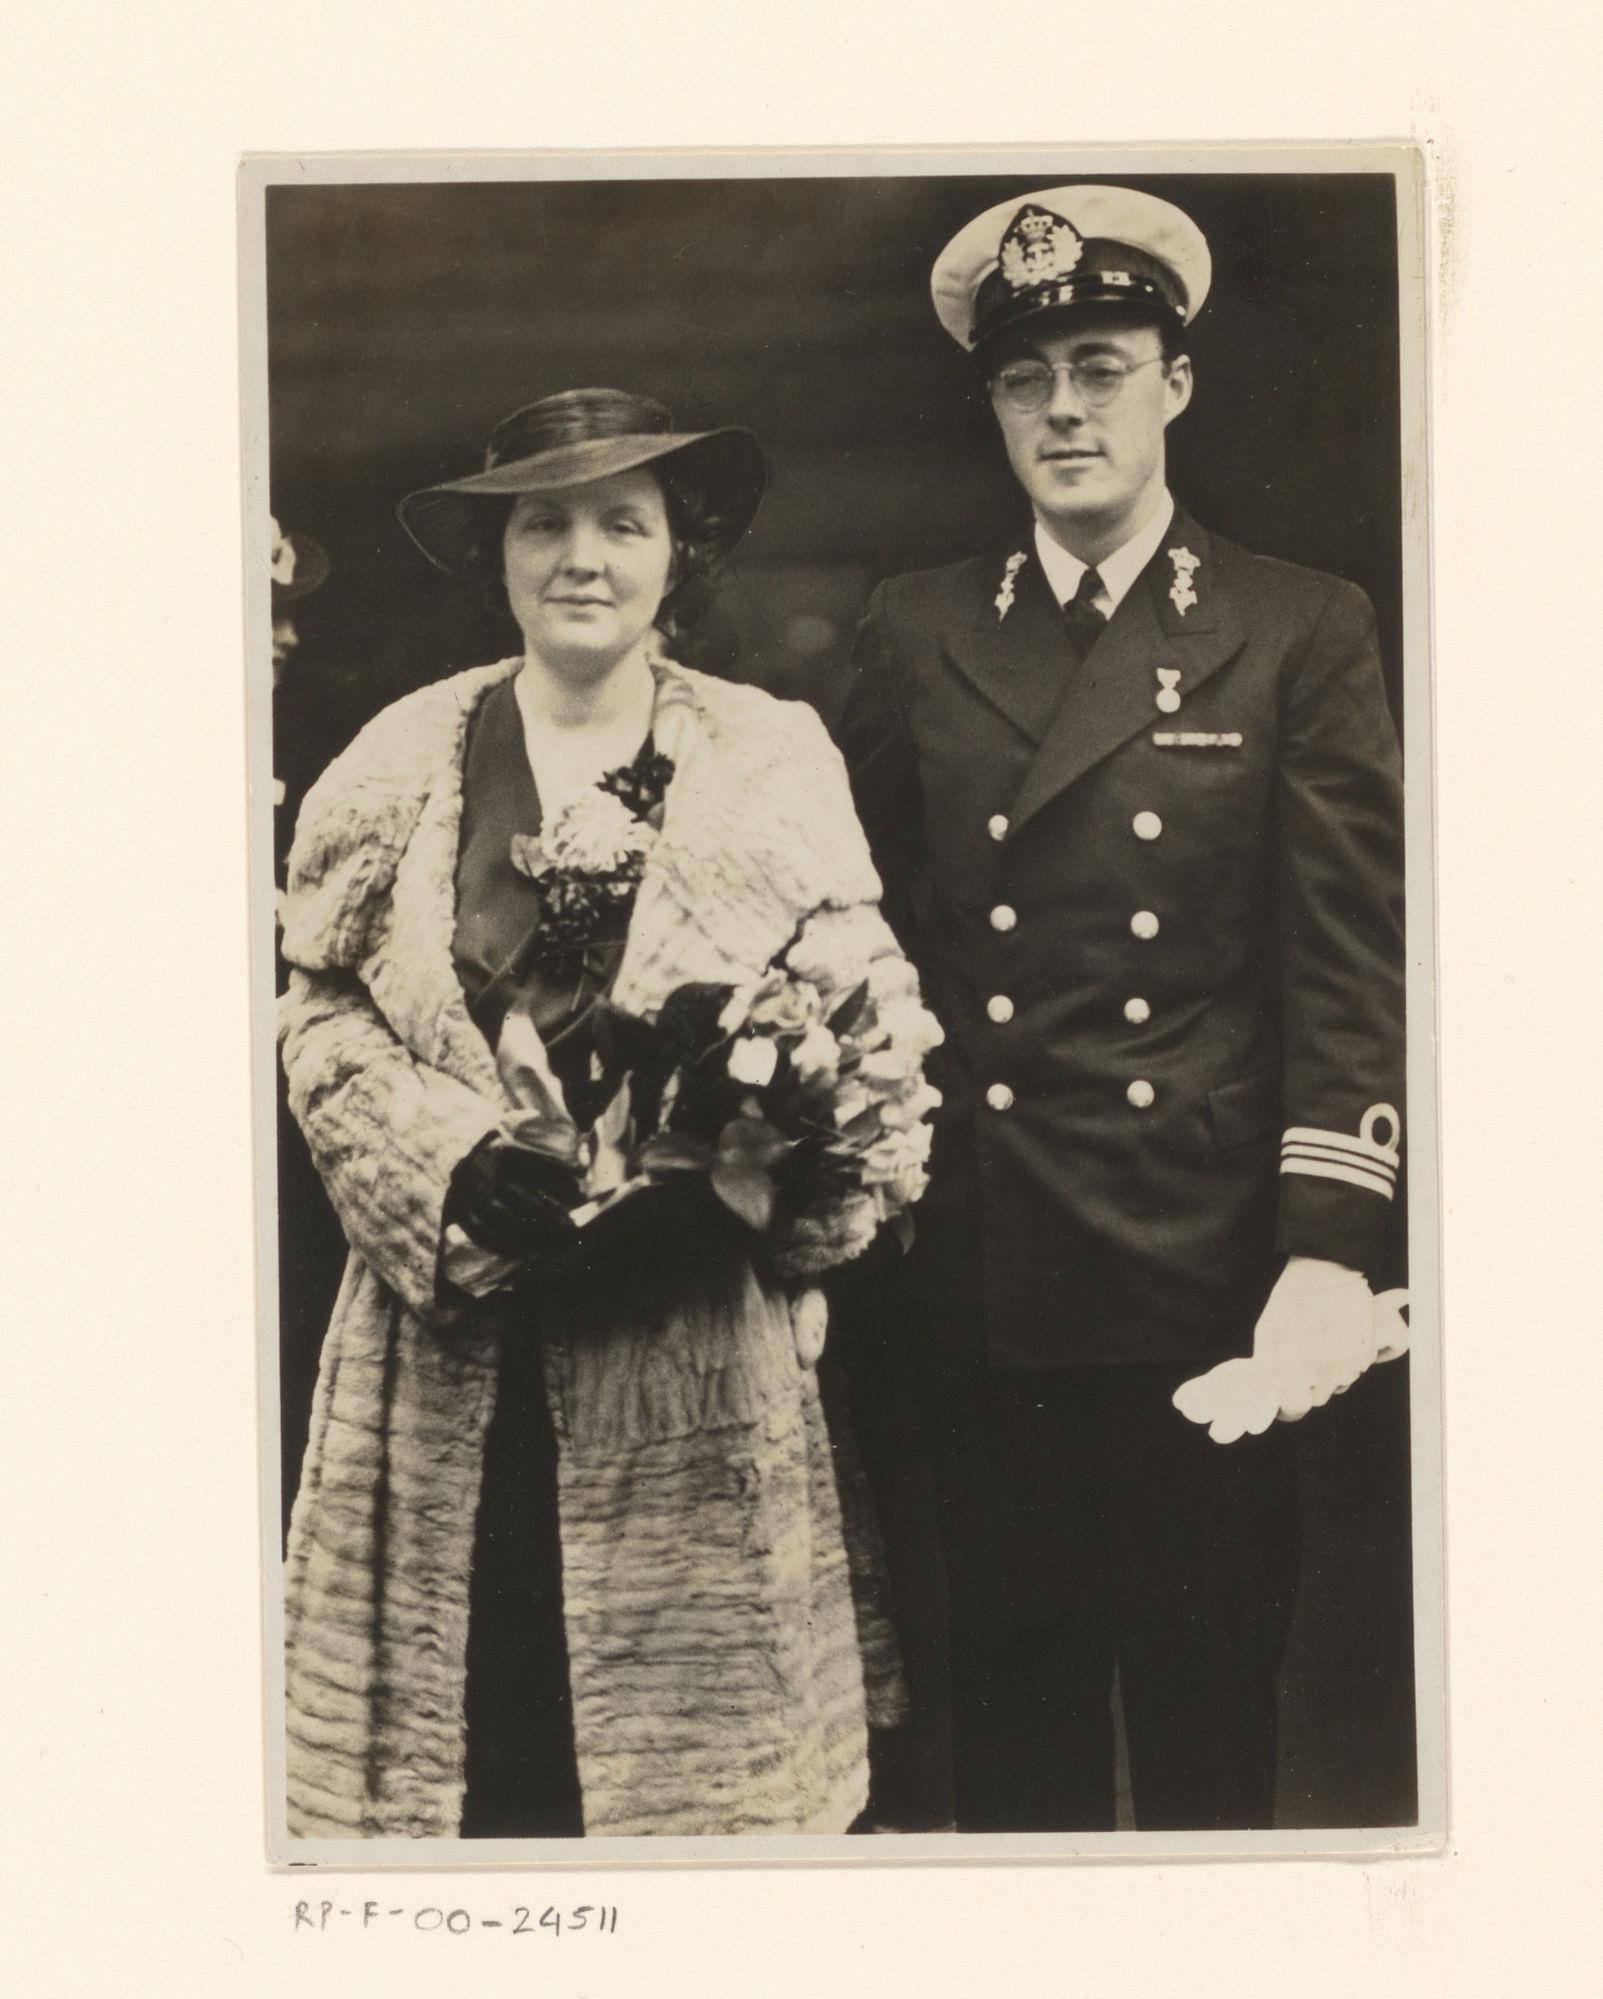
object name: photograph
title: H.K.H. Prinses Juliana en Z.K.H. Prins Bernhard terugkeerende van de Kroningsfeesten te London, 22 Mei 1937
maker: Anonymous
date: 1937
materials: paper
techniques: gelatin silver print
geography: amsterdam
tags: utrecht, bernhard (prins der nederlanden), juliana of the netherlands, historical persons - bb - woman, historical persons not known by name